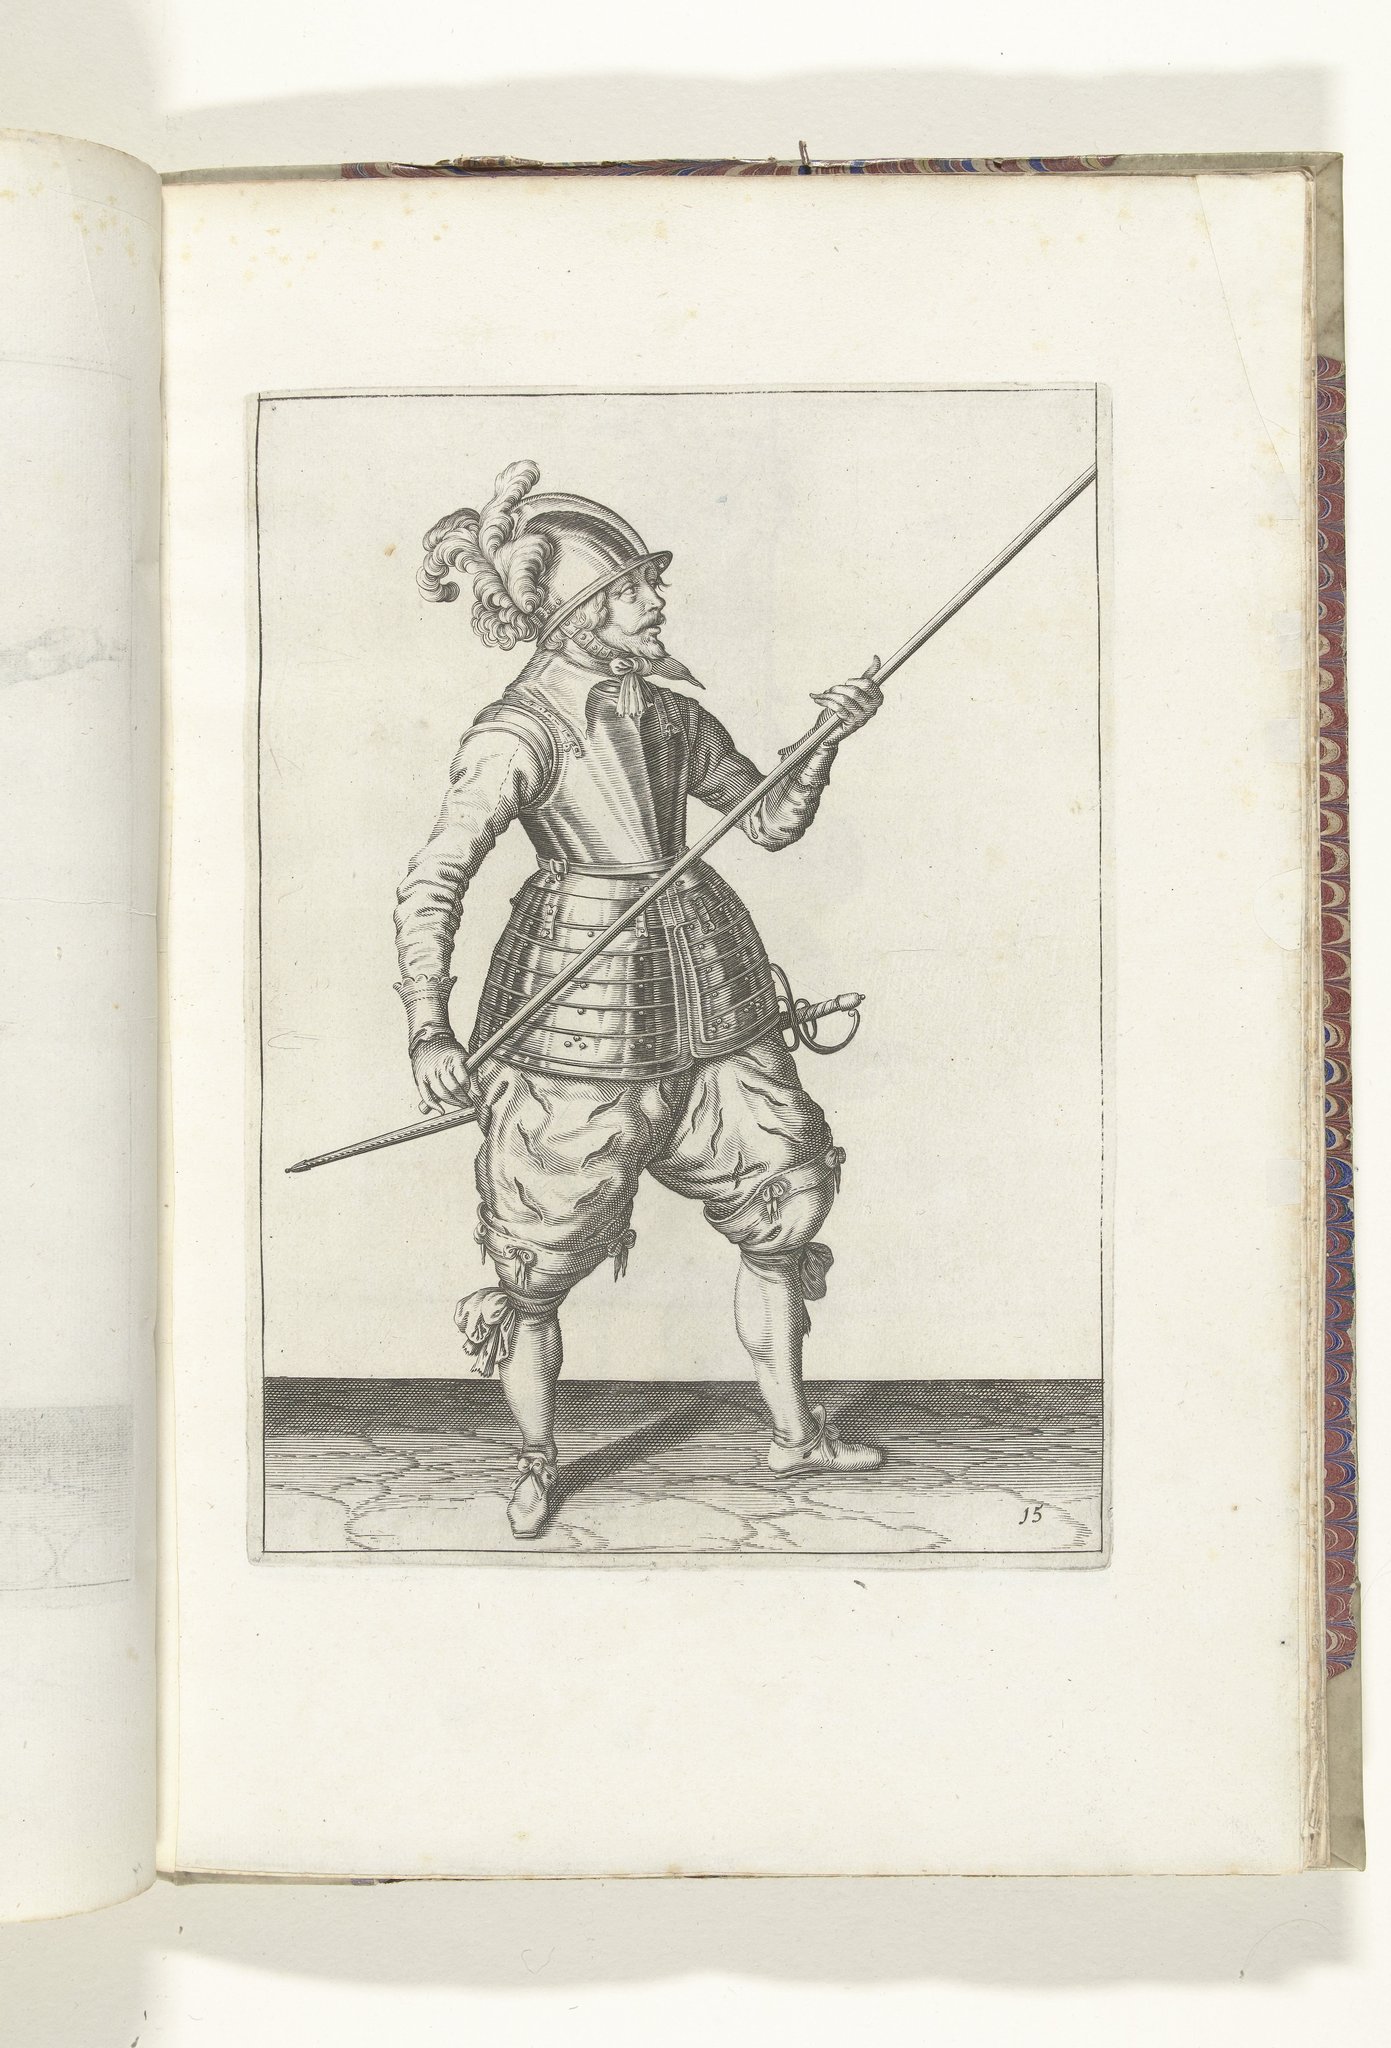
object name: print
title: Soldaat die zijn spies met beide handen bij zijn rechterzijde draagt, de punt schuin omhoog gericht (nr. 15), ca. 1600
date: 1597-1607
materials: paper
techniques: engraving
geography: northern netherlands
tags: maurice (prince of orange), handling of weapons ~ military training, weapons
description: Een soldaat, ten voeten uit, die een spies (lans) met beide handen bij zijn rechterzijde draagt, de punt schuin omhoog gericht (nr. 15), ca. 1600. Dit is de eerste handeling voor het op de grond plaatsen van de spies. Plaat 15 in de instructies voor het hanteren van de spies: Corte onderwysinghe op de figuerliicke afbeeldinghe belanghende trechte gebruck, van alle t'ghene een Soldaet int handelen vande Spies noodich is. Onderdeel van de illustraties in: J. de Gheyn, Wapenhandelinghe van Roers Musquetten ende spiessen, Amsterdam, 1608. Krijgswezen rond 1600.